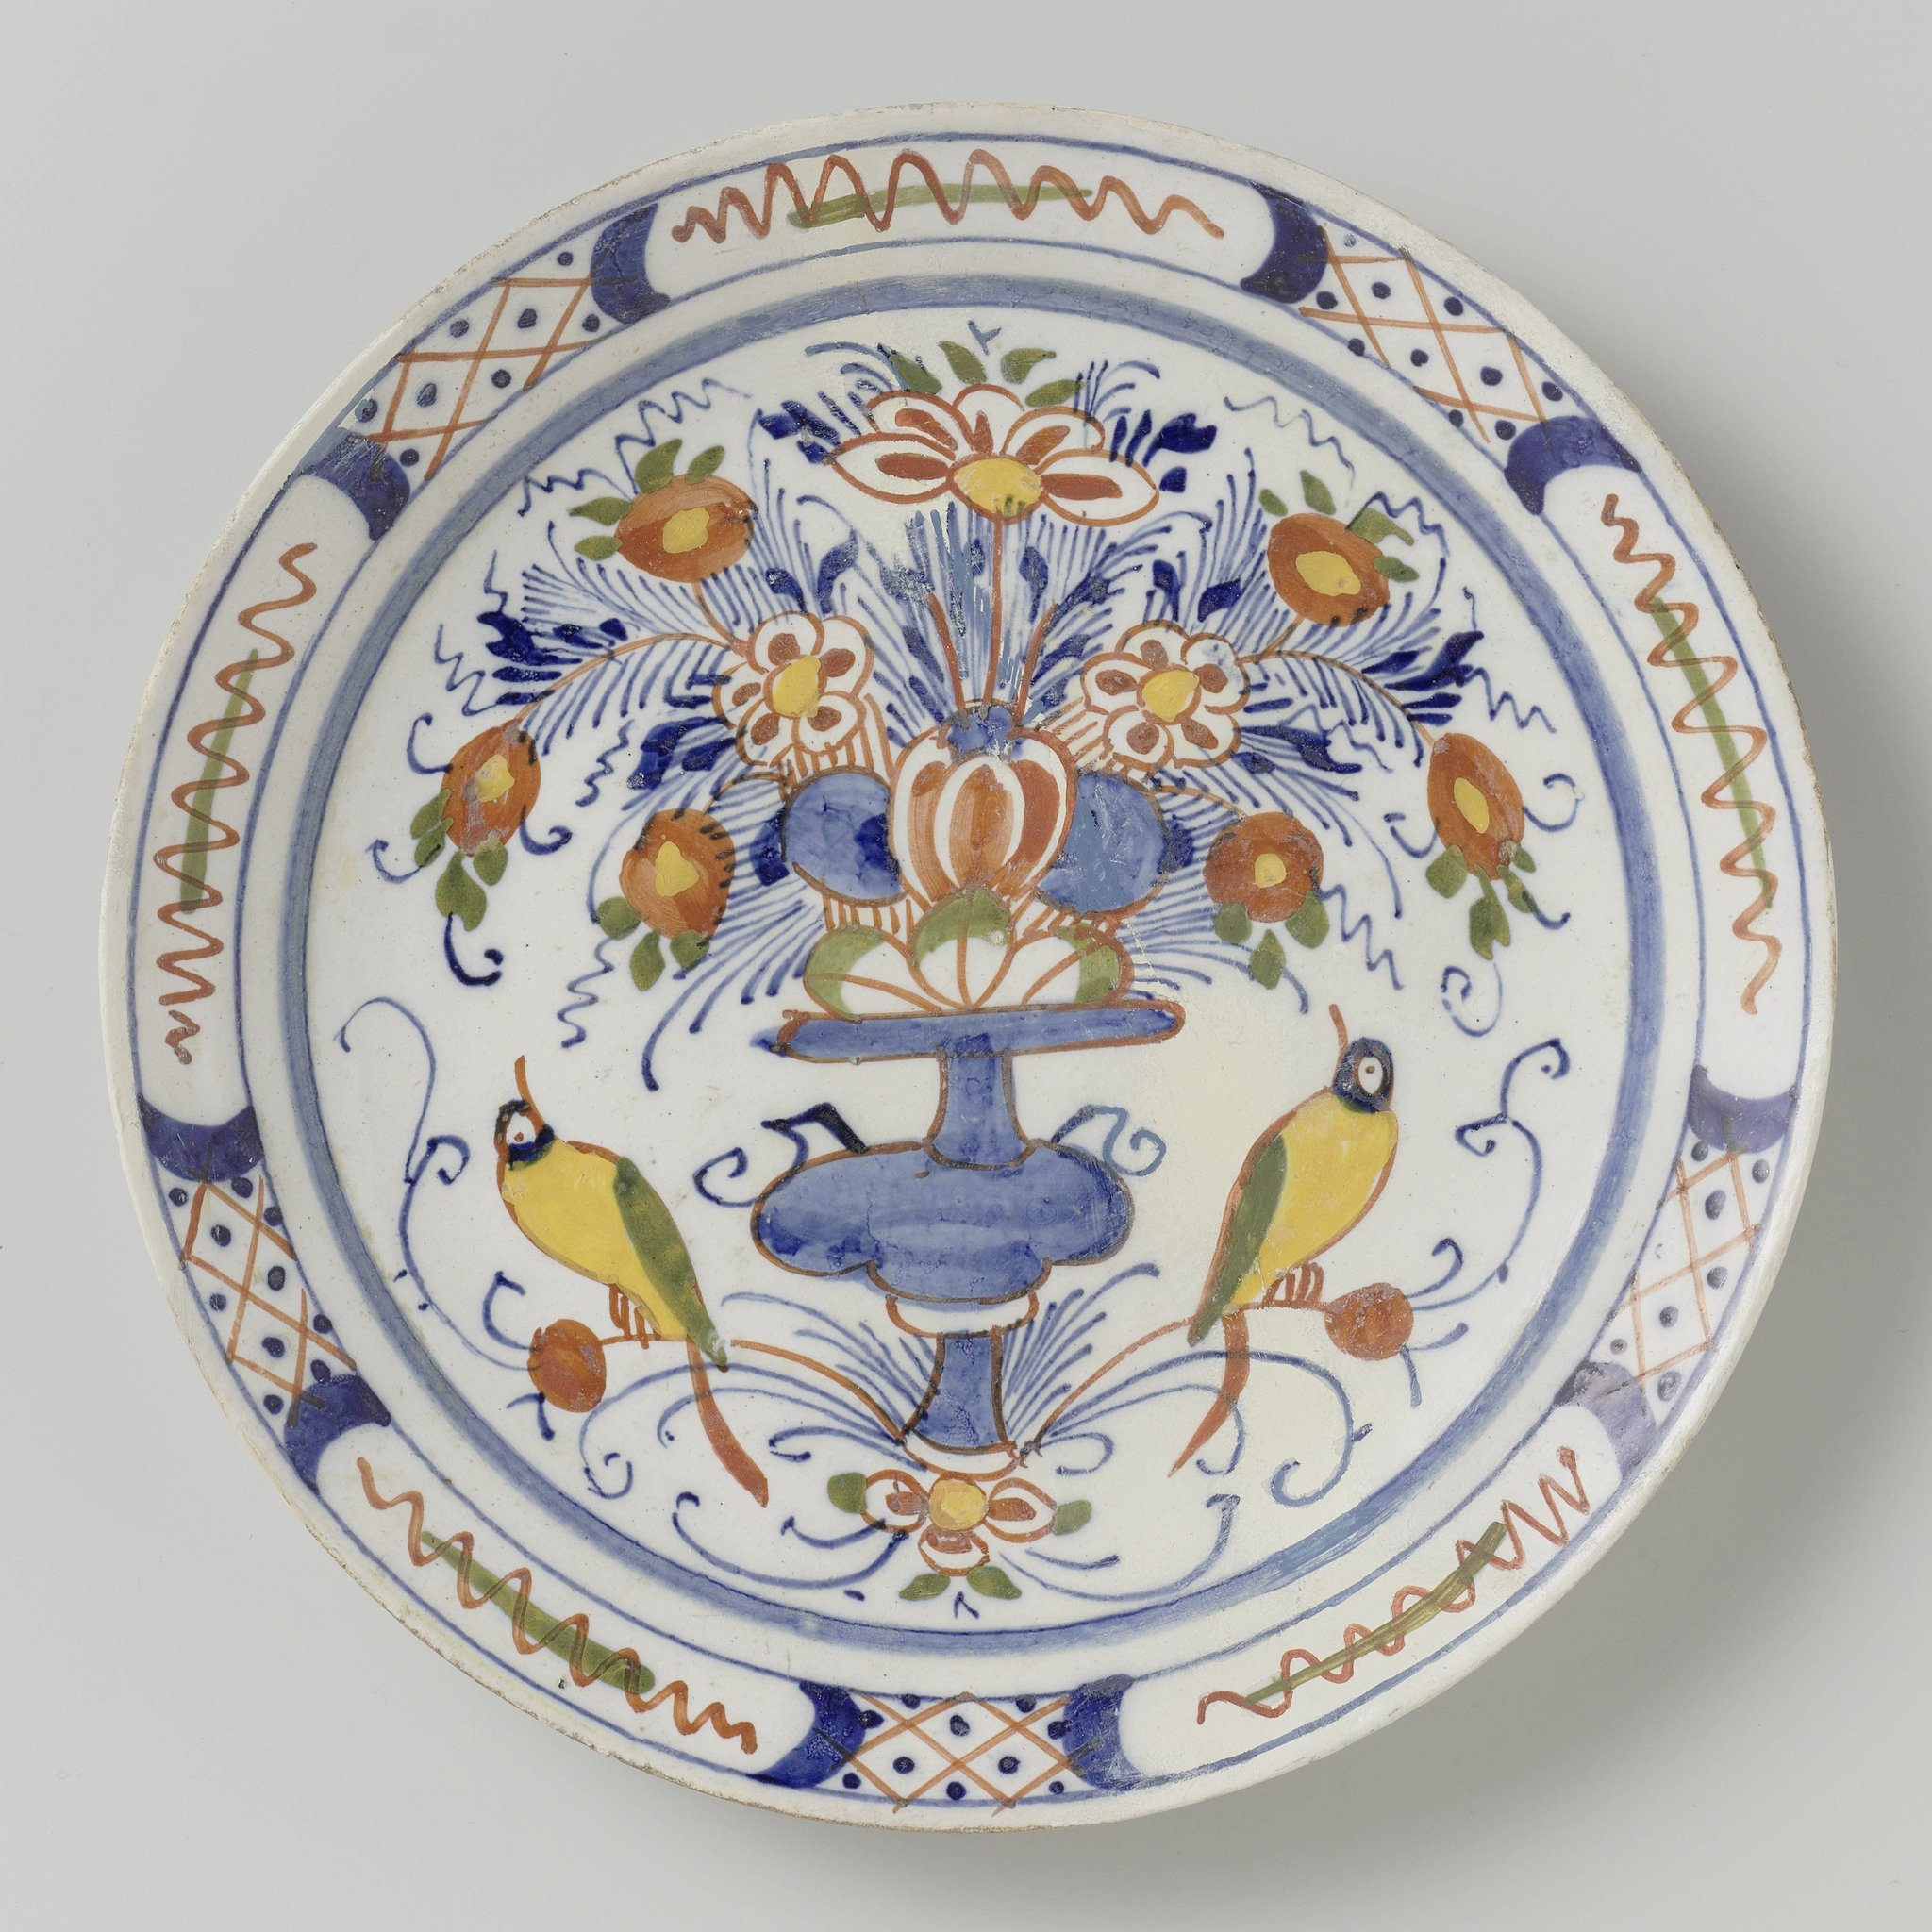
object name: plate dish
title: bord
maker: Anonymous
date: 1750-1780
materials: earthenware, glaze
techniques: painted, polychromy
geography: delft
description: Rond bord van veelkleurig beschilderde faience. Op het plat zijn een bloemenvaas en twee vogels geschilderd en op de rand een Chinees motief. Bij het bord horen drie identieke borden met de invnrs. BK-KOG-2424-a, BK-KOG-2424-b en BK-KOG-2424-d.